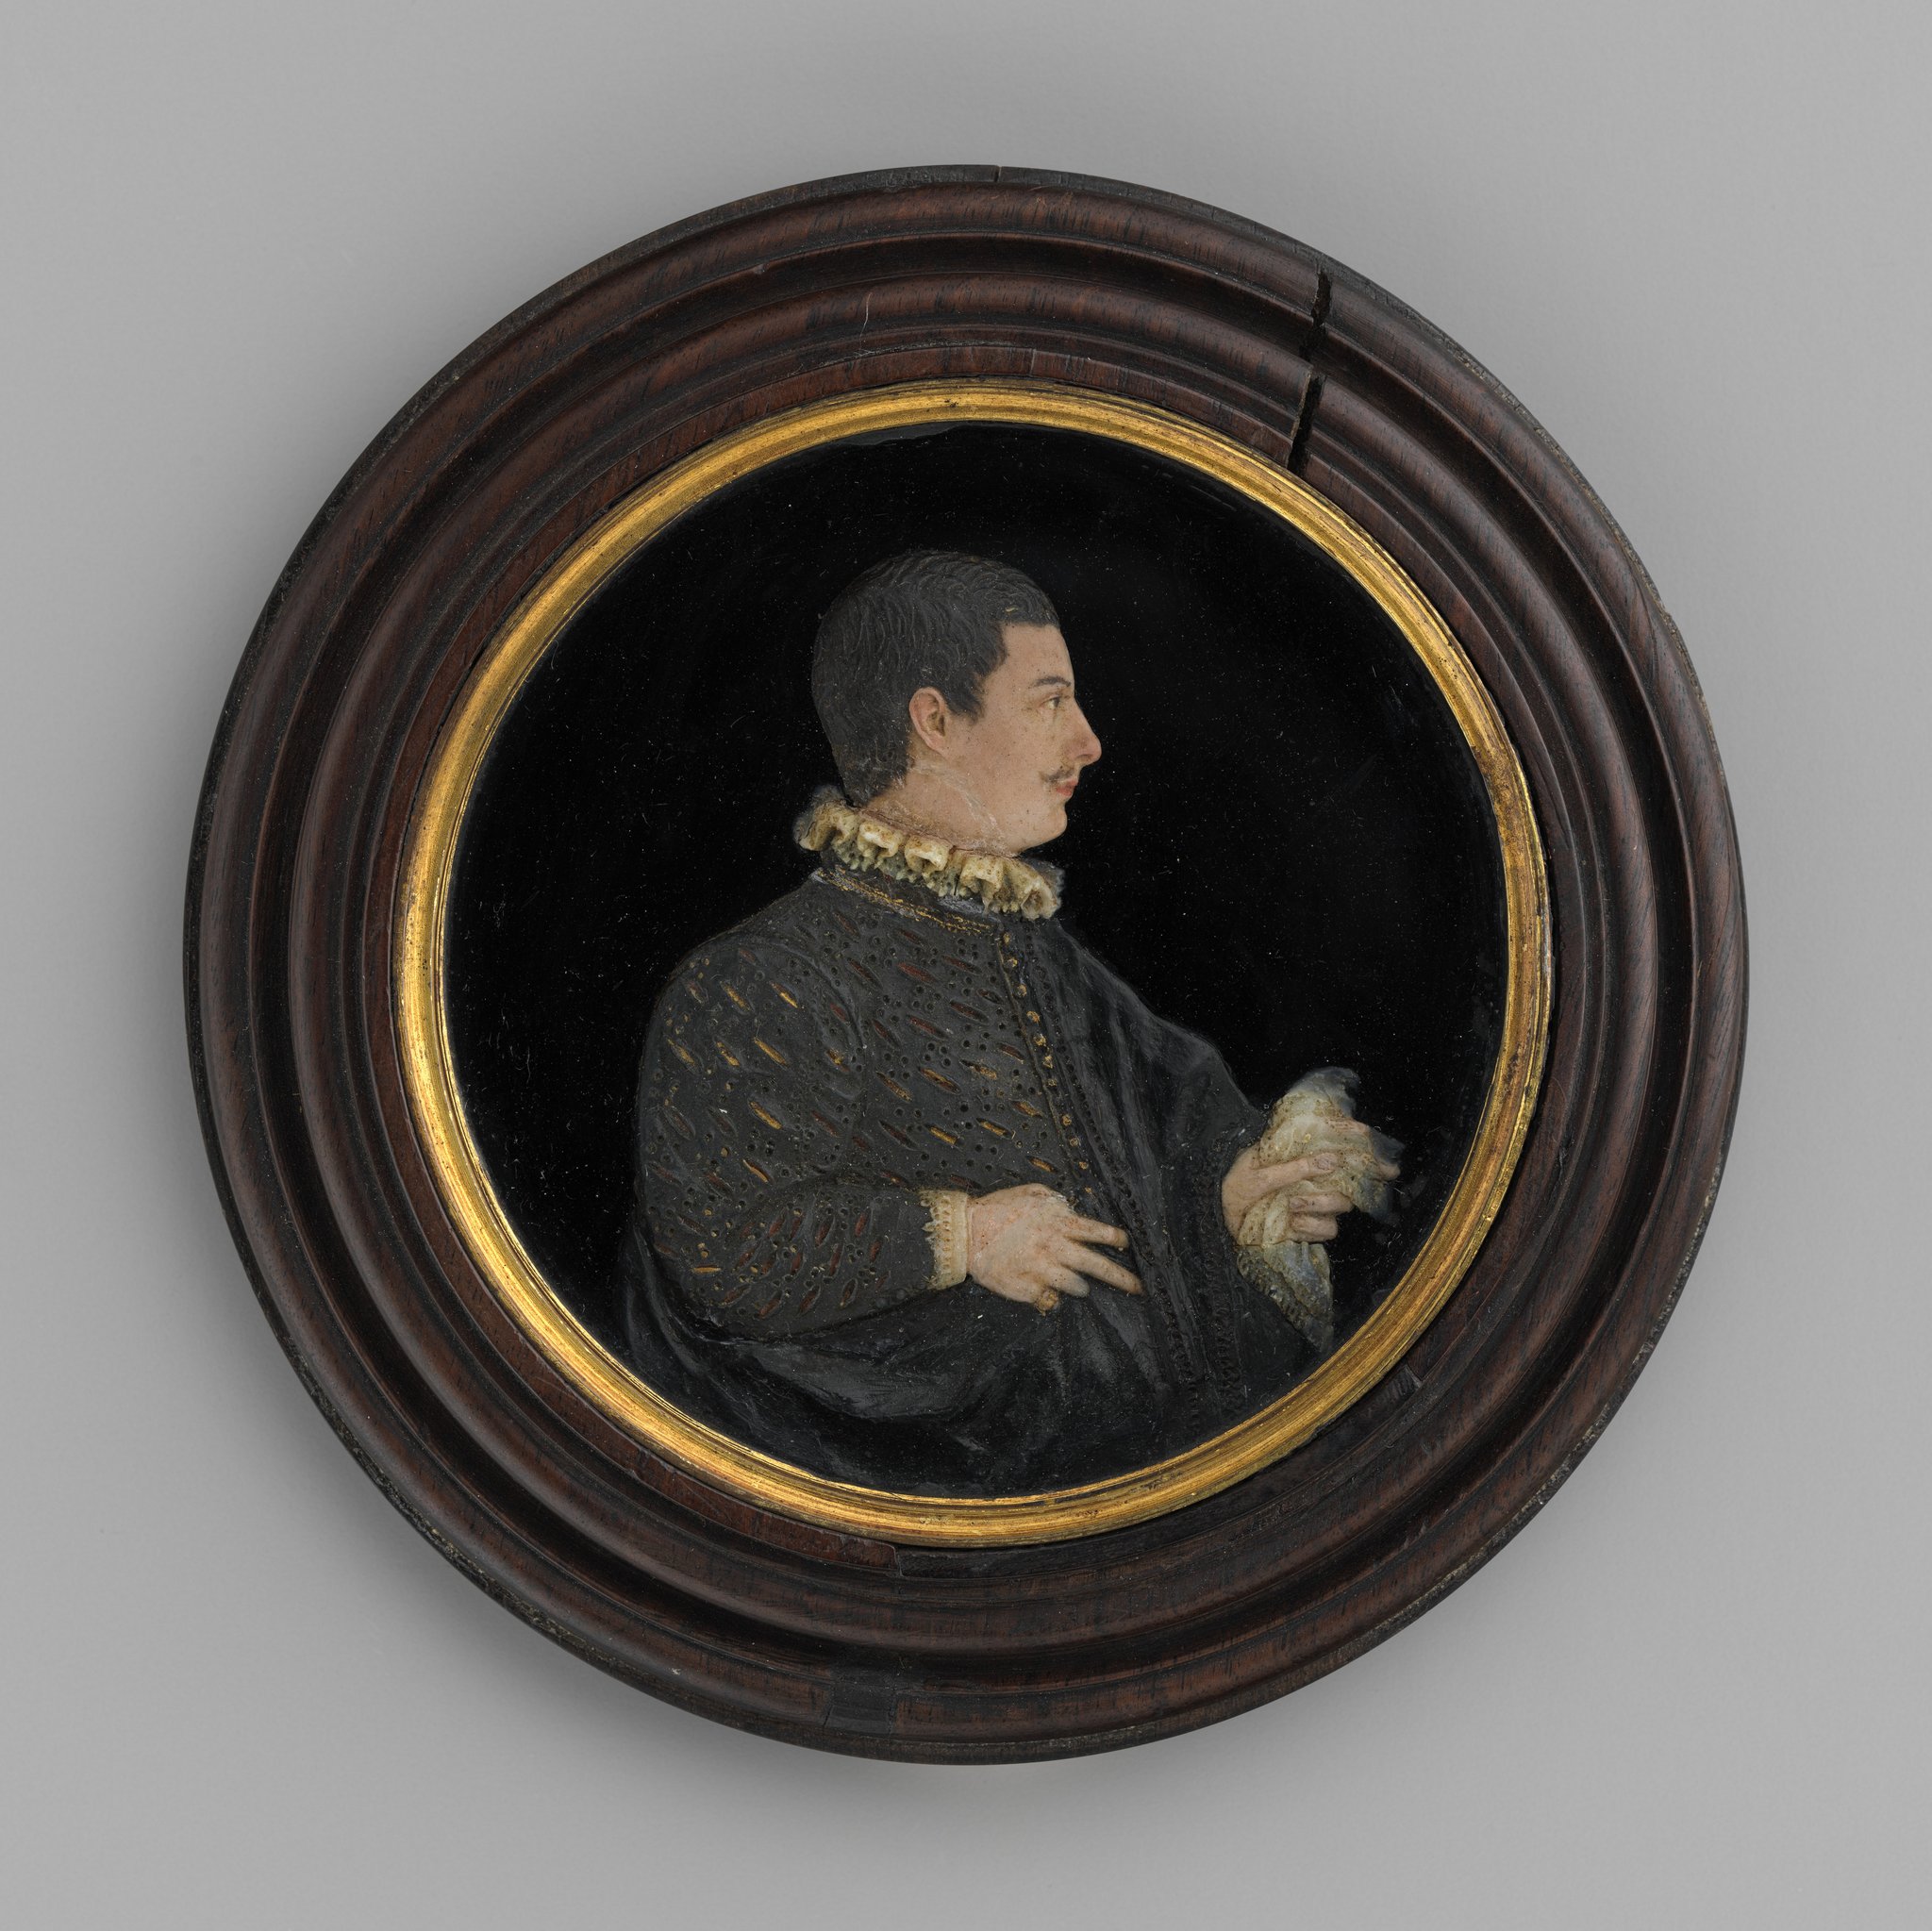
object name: relief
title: Portrait of a gentleman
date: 1565-1585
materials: glass, pearl, wax, wood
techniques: gilding, relief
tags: men,portraits